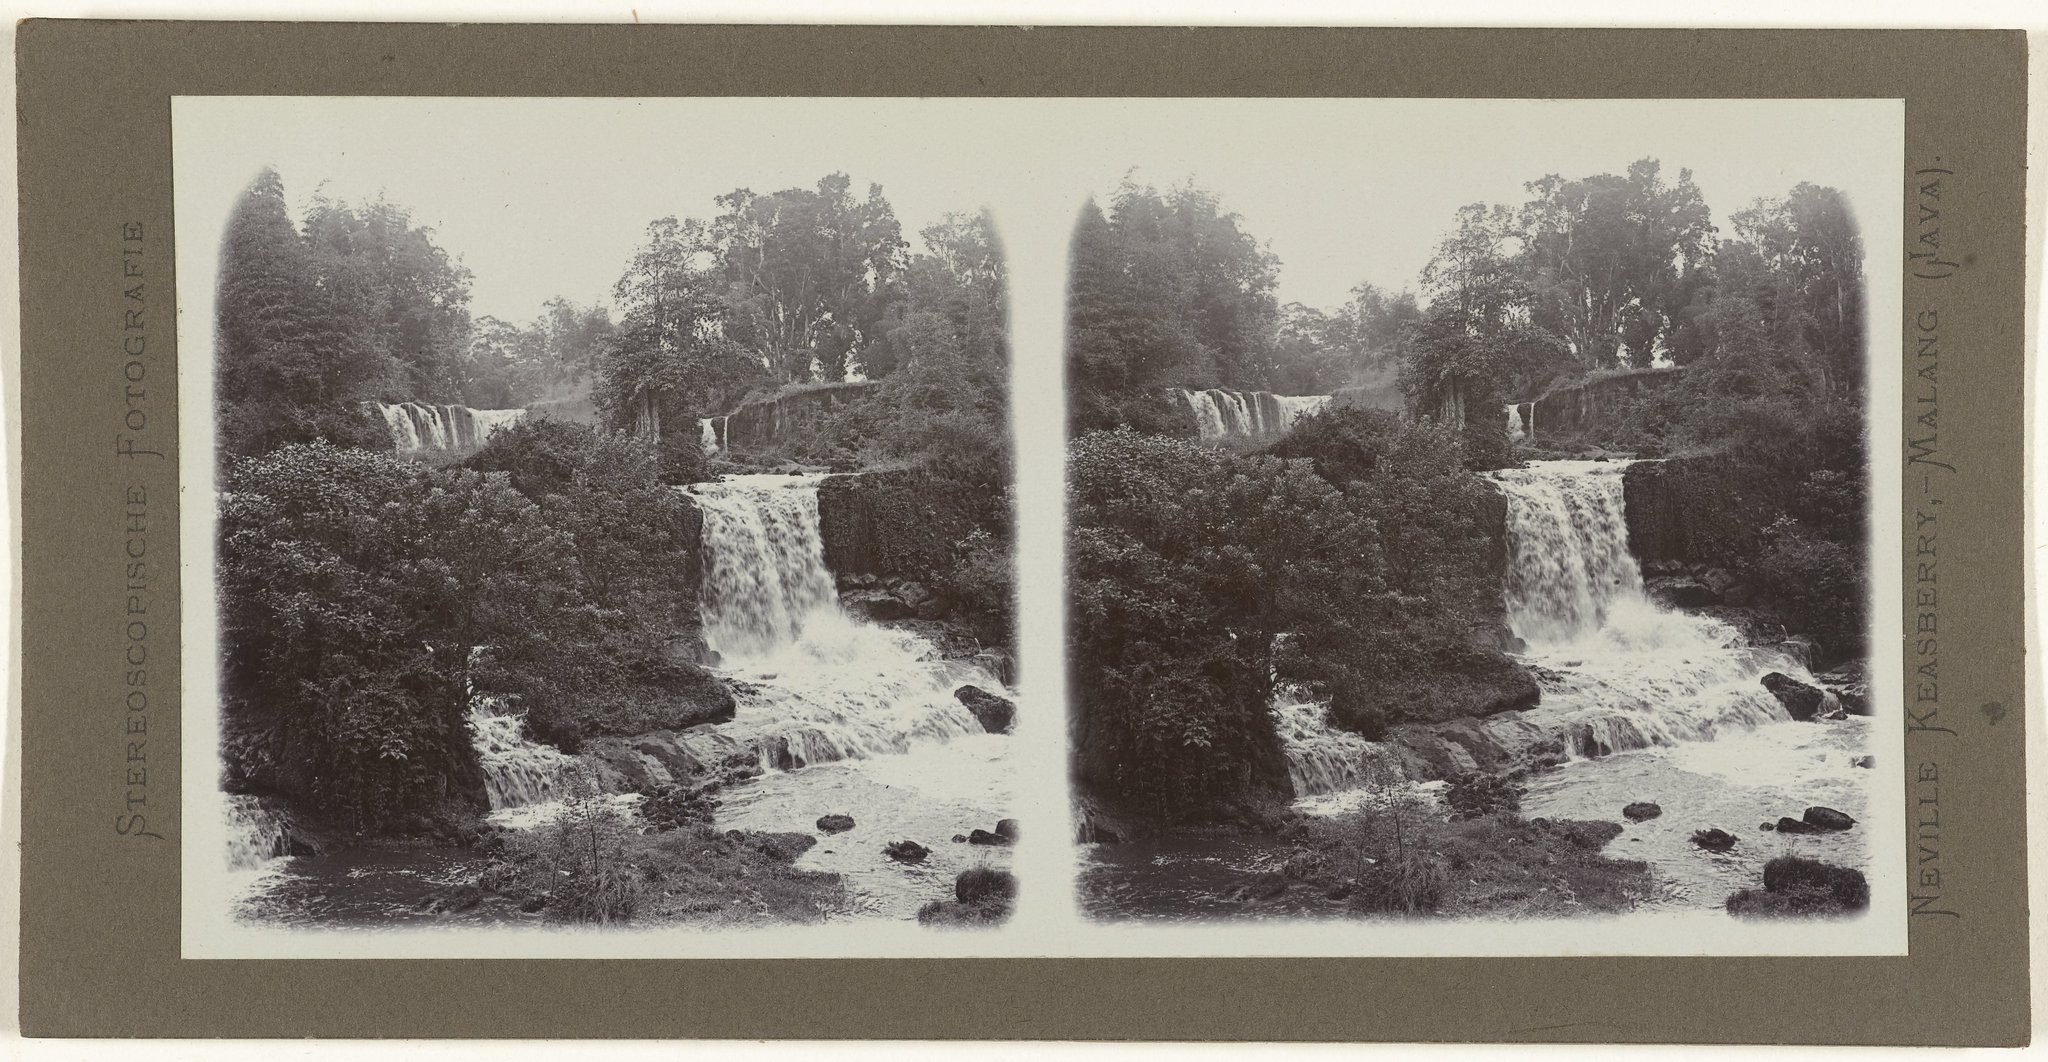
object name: stereograph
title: Watervallen in een rivier nabij Malang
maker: neville keasberry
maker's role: fotograaf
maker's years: 1866-1944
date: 1900-1935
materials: cardboard, paper, photographic support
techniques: albumen print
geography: malang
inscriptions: inscription: ‘Stereoscopische Fotografie’, signature: ‘Neville Keasberry, Malang (Java)’